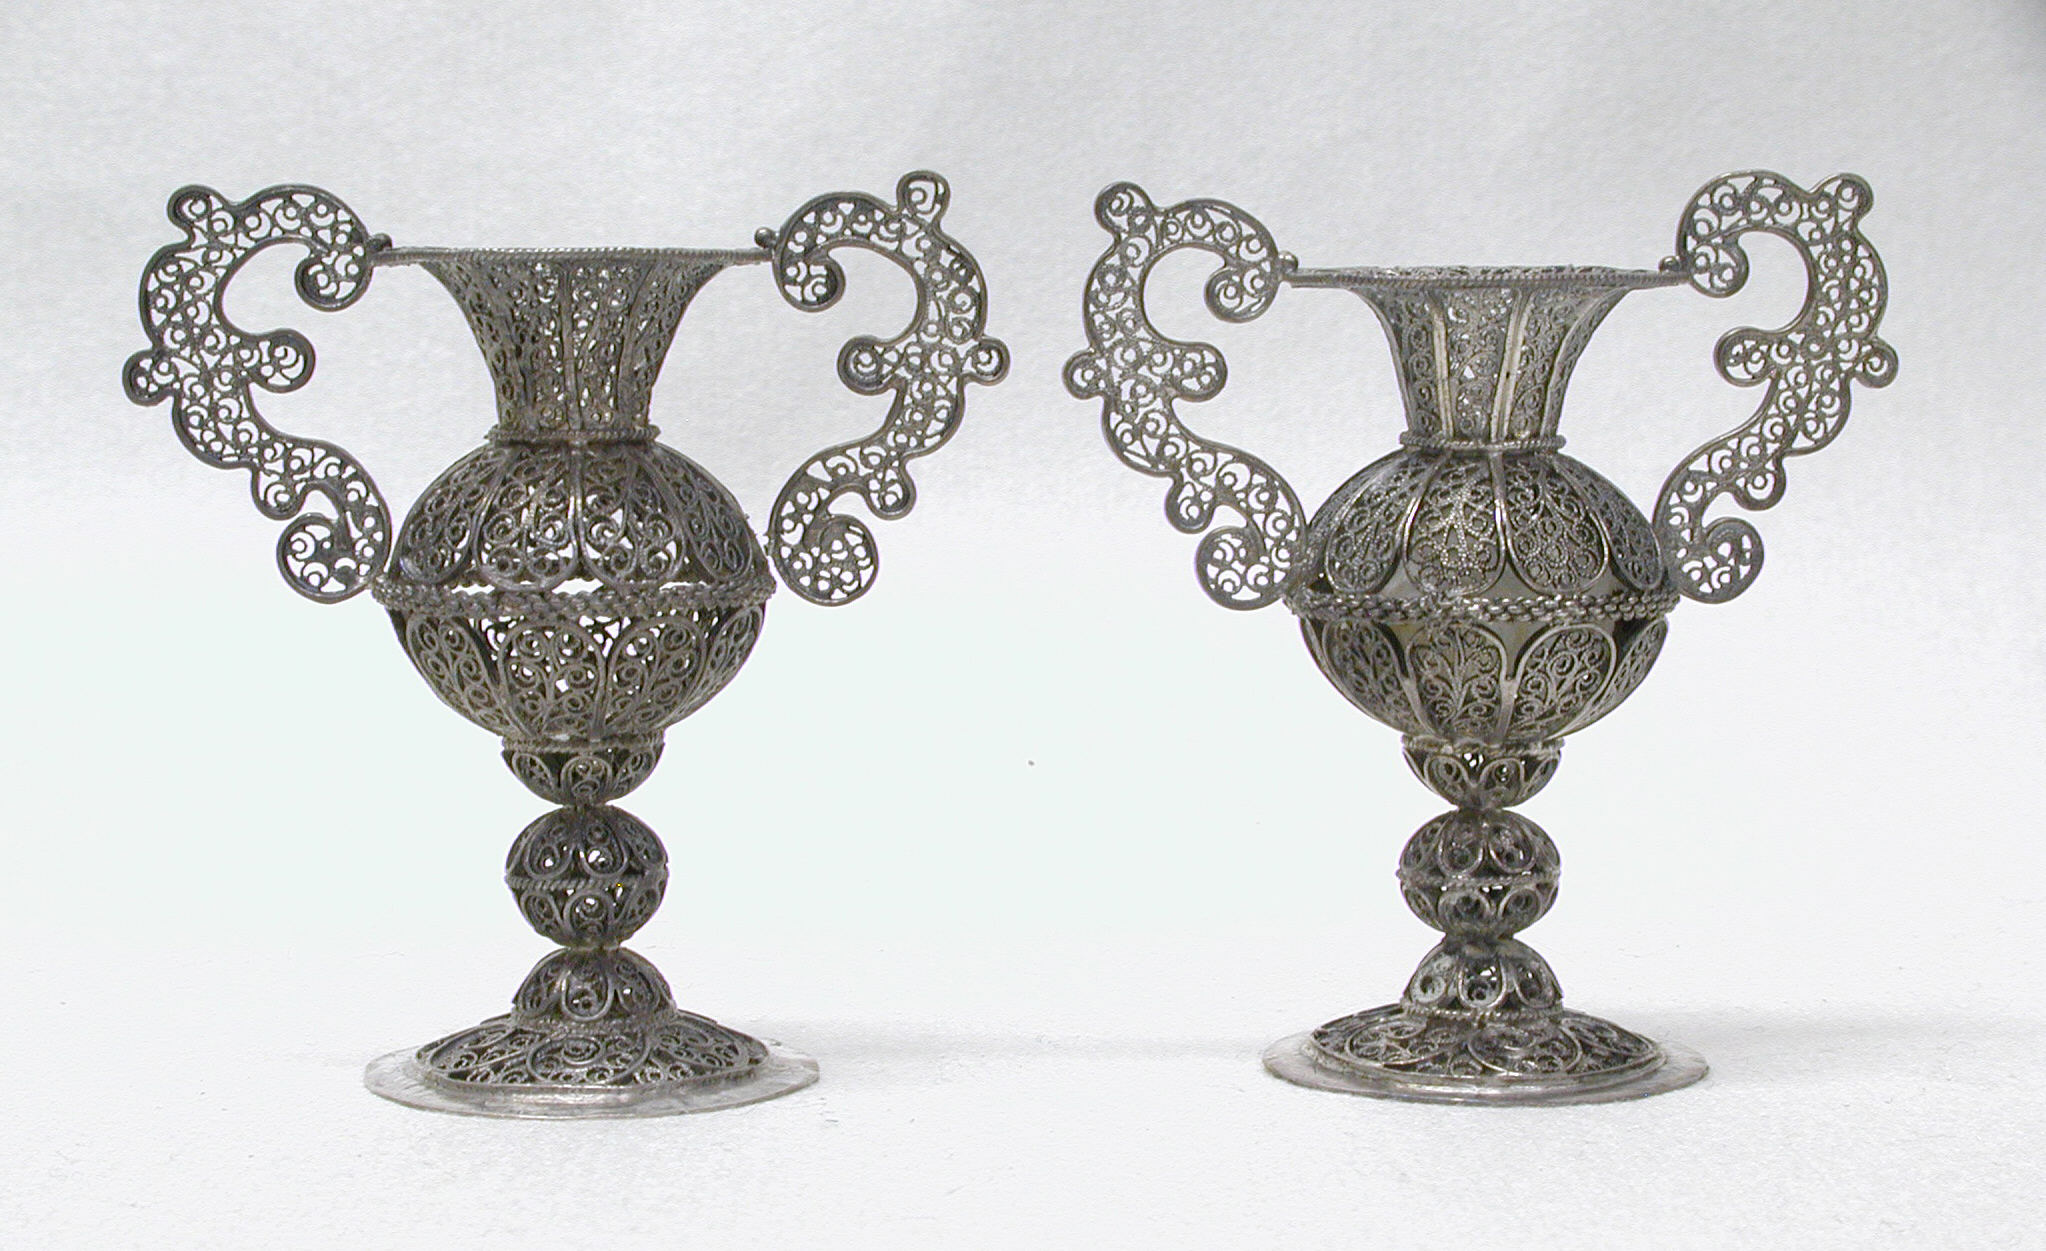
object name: urn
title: Miniature urn (one of a pair) (part of a set)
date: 1675-1700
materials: silver